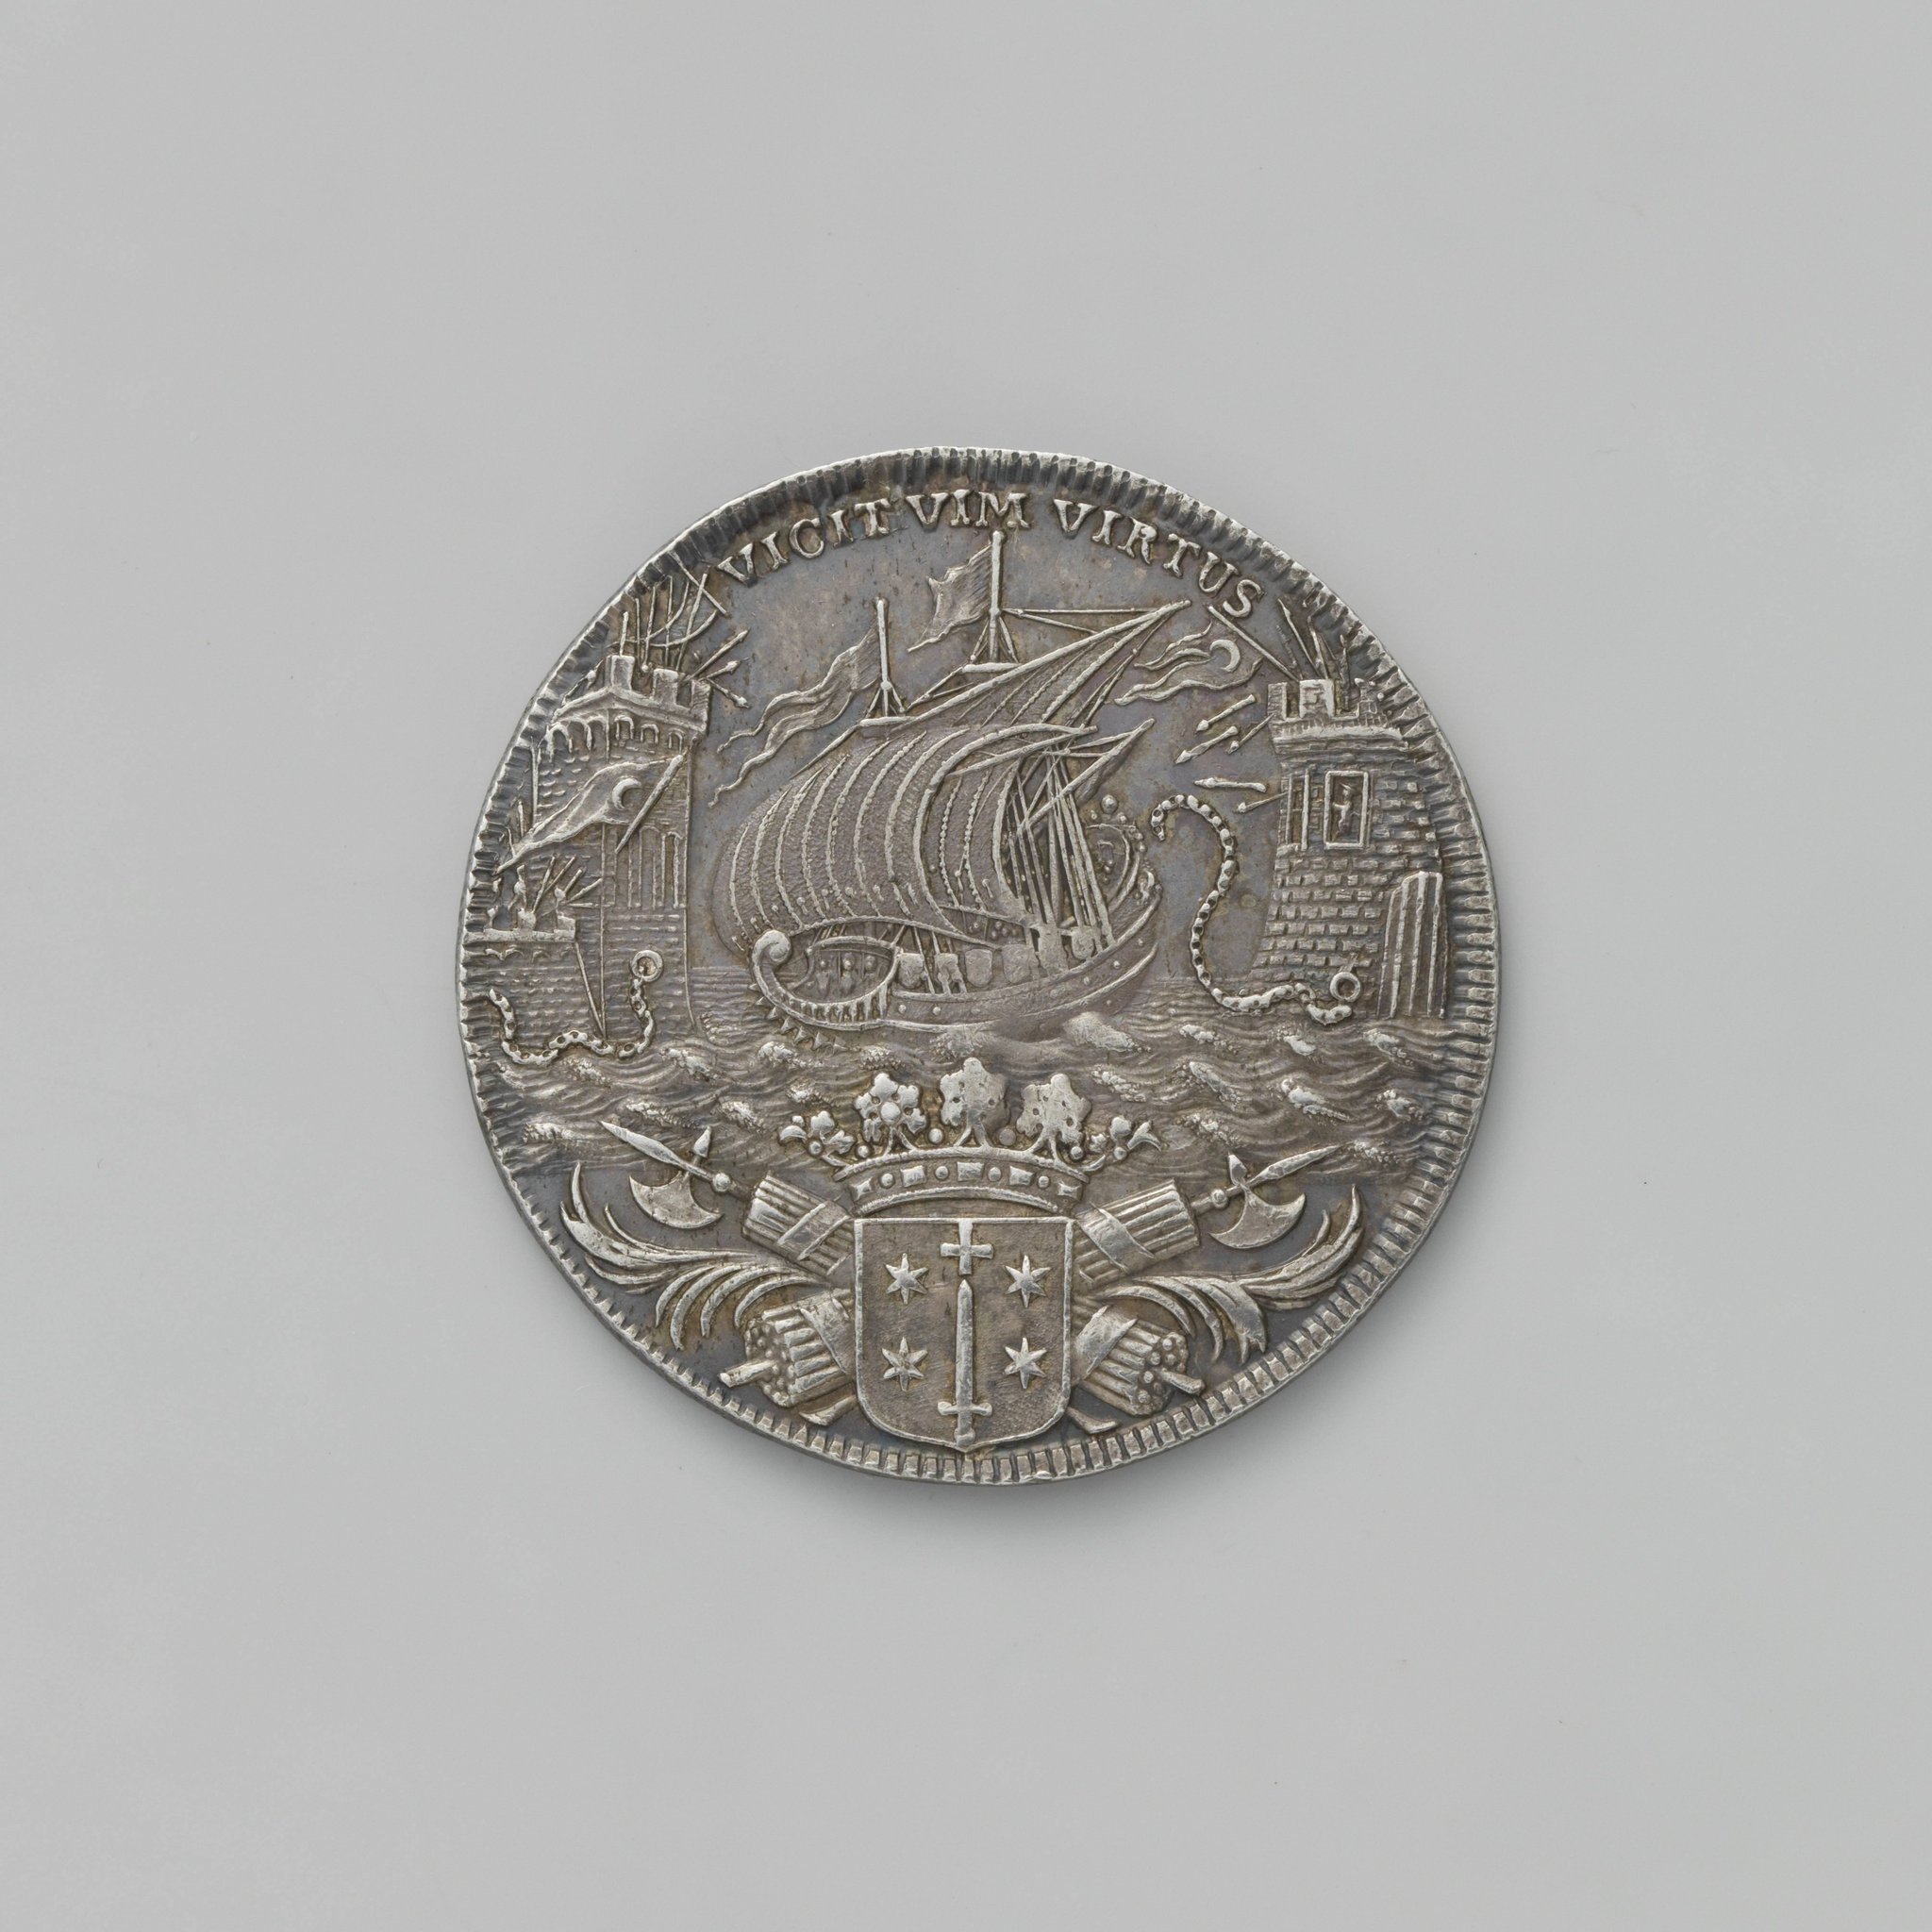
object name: council medal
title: Vroedschapspenning van de stad Haarlem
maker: daniel drappentier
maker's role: medailleur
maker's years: 1643-1714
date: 1688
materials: silver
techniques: striking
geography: haarlem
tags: haarlem